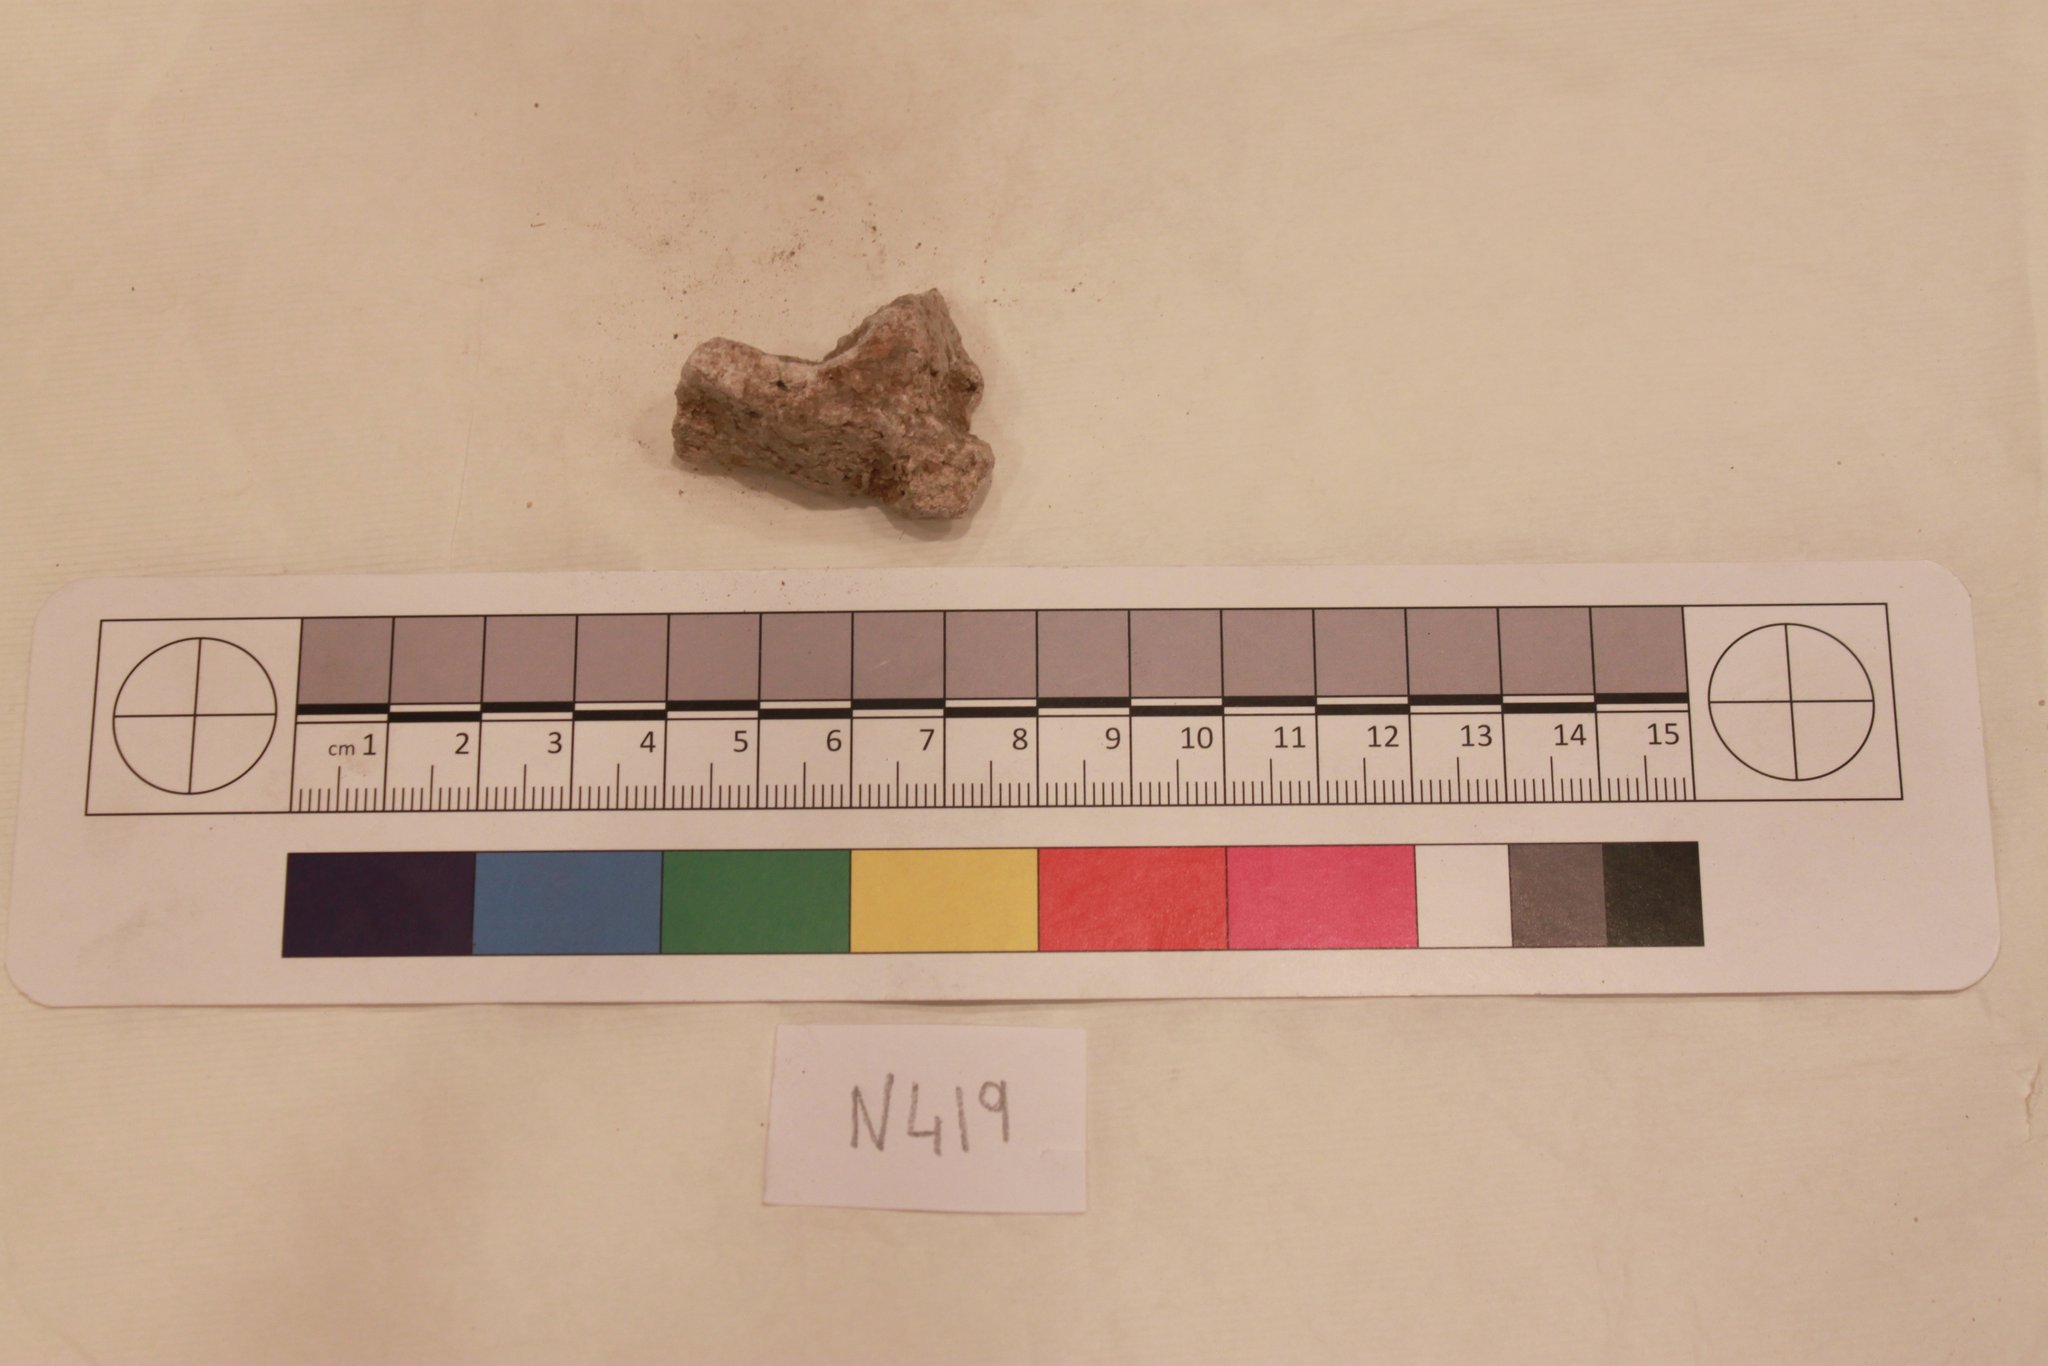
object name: fragment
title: Stucco Fragment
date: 701-1200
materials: plaster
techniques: carving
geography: iran